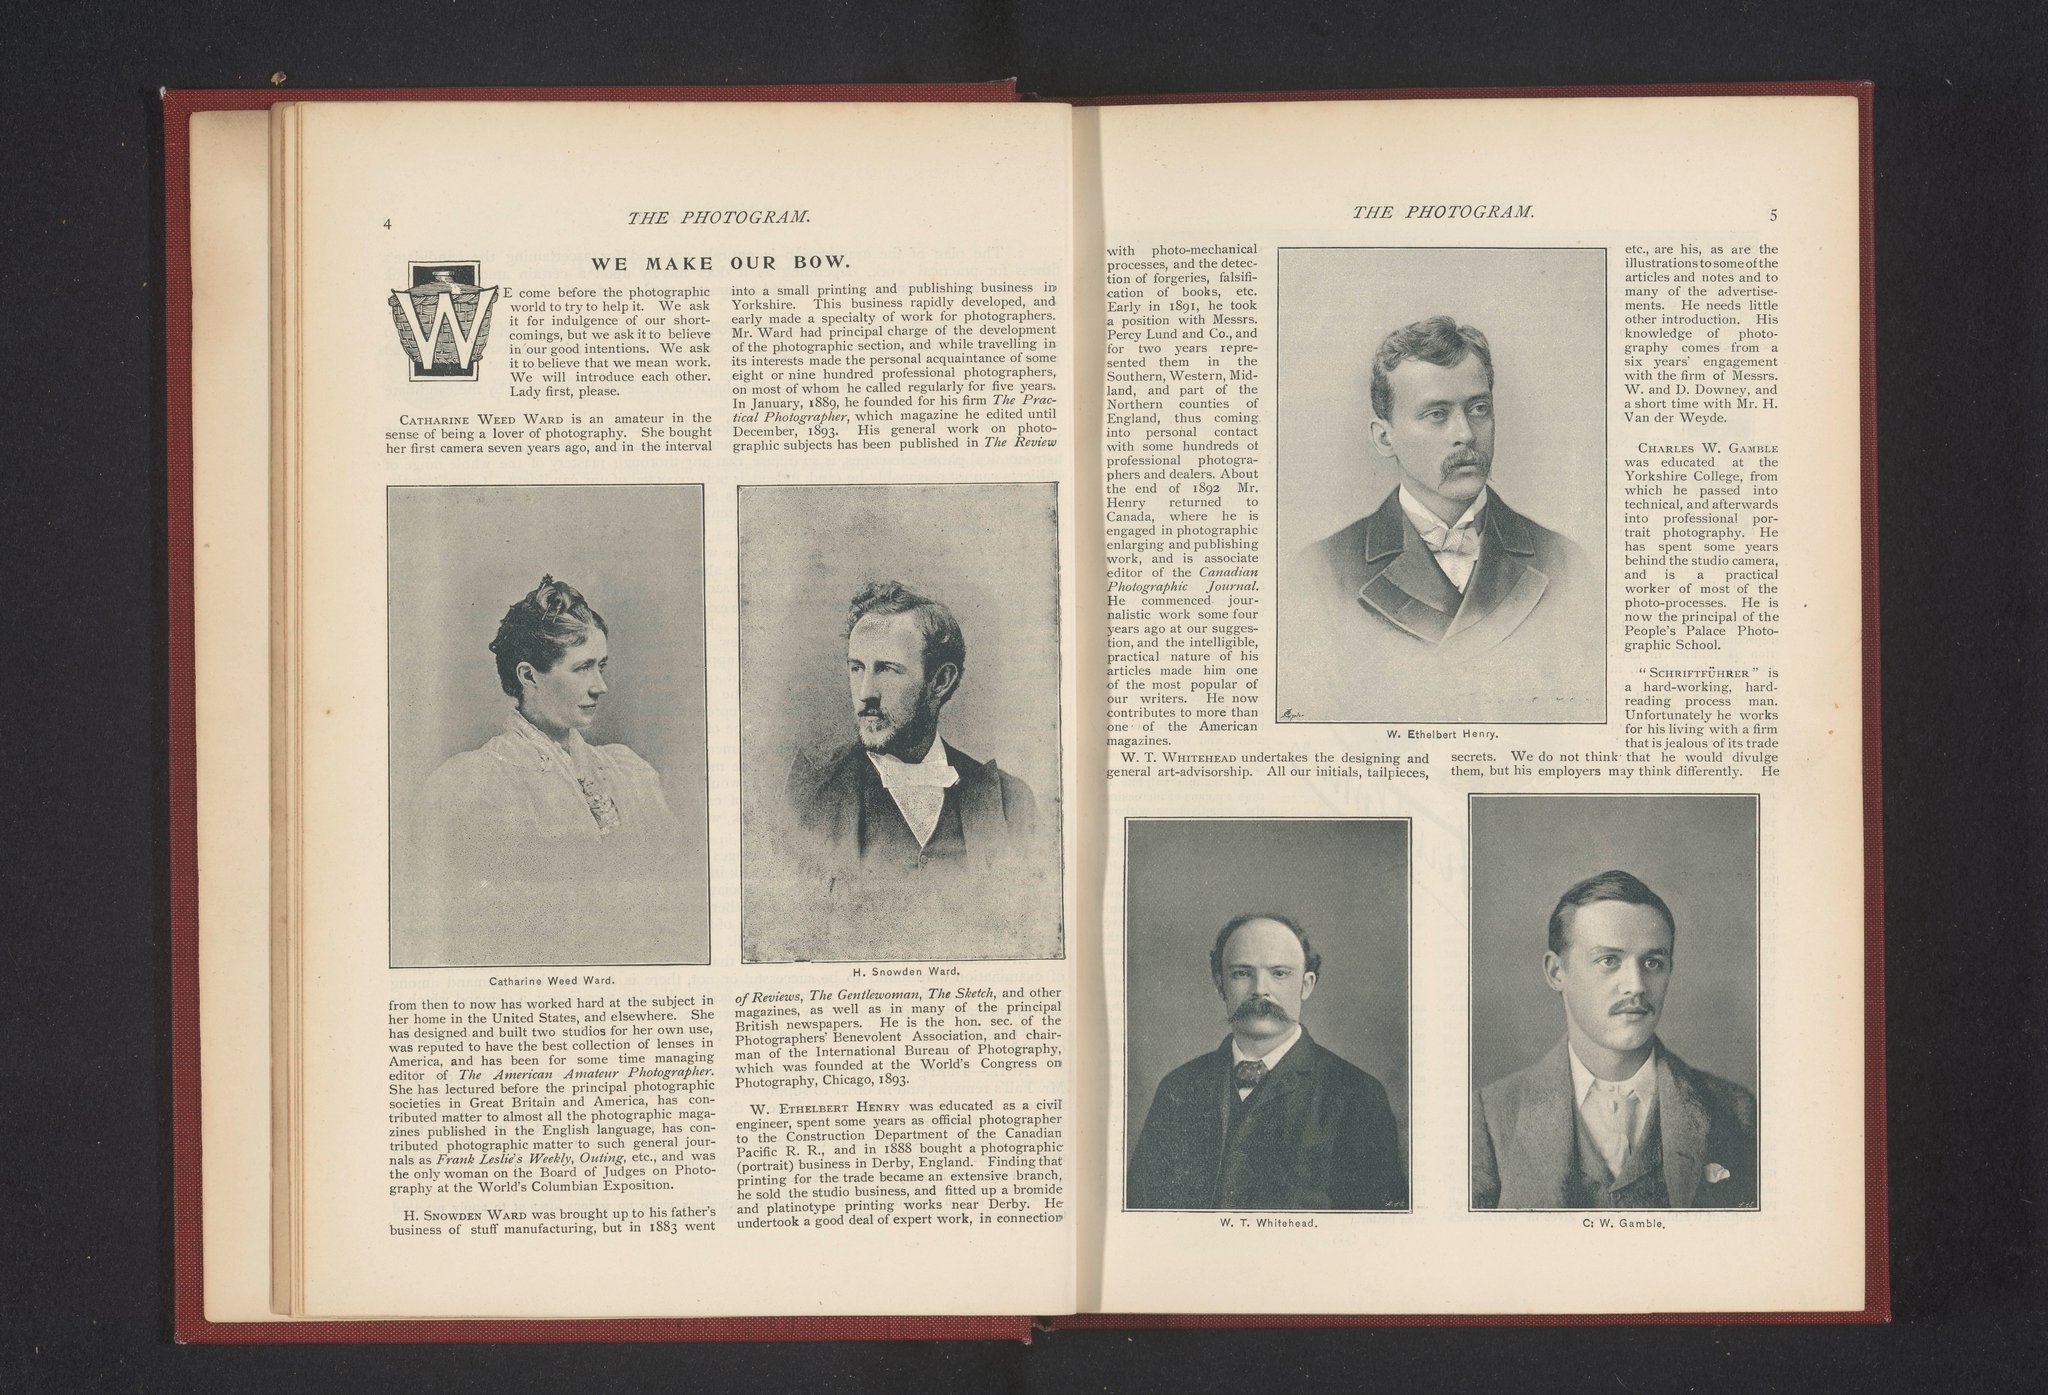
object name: page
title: Charles W. Gamble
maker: Anonymous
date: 1889-1894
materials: paper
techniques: autotype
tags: historical persons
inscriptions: monogram: ‘A & S’